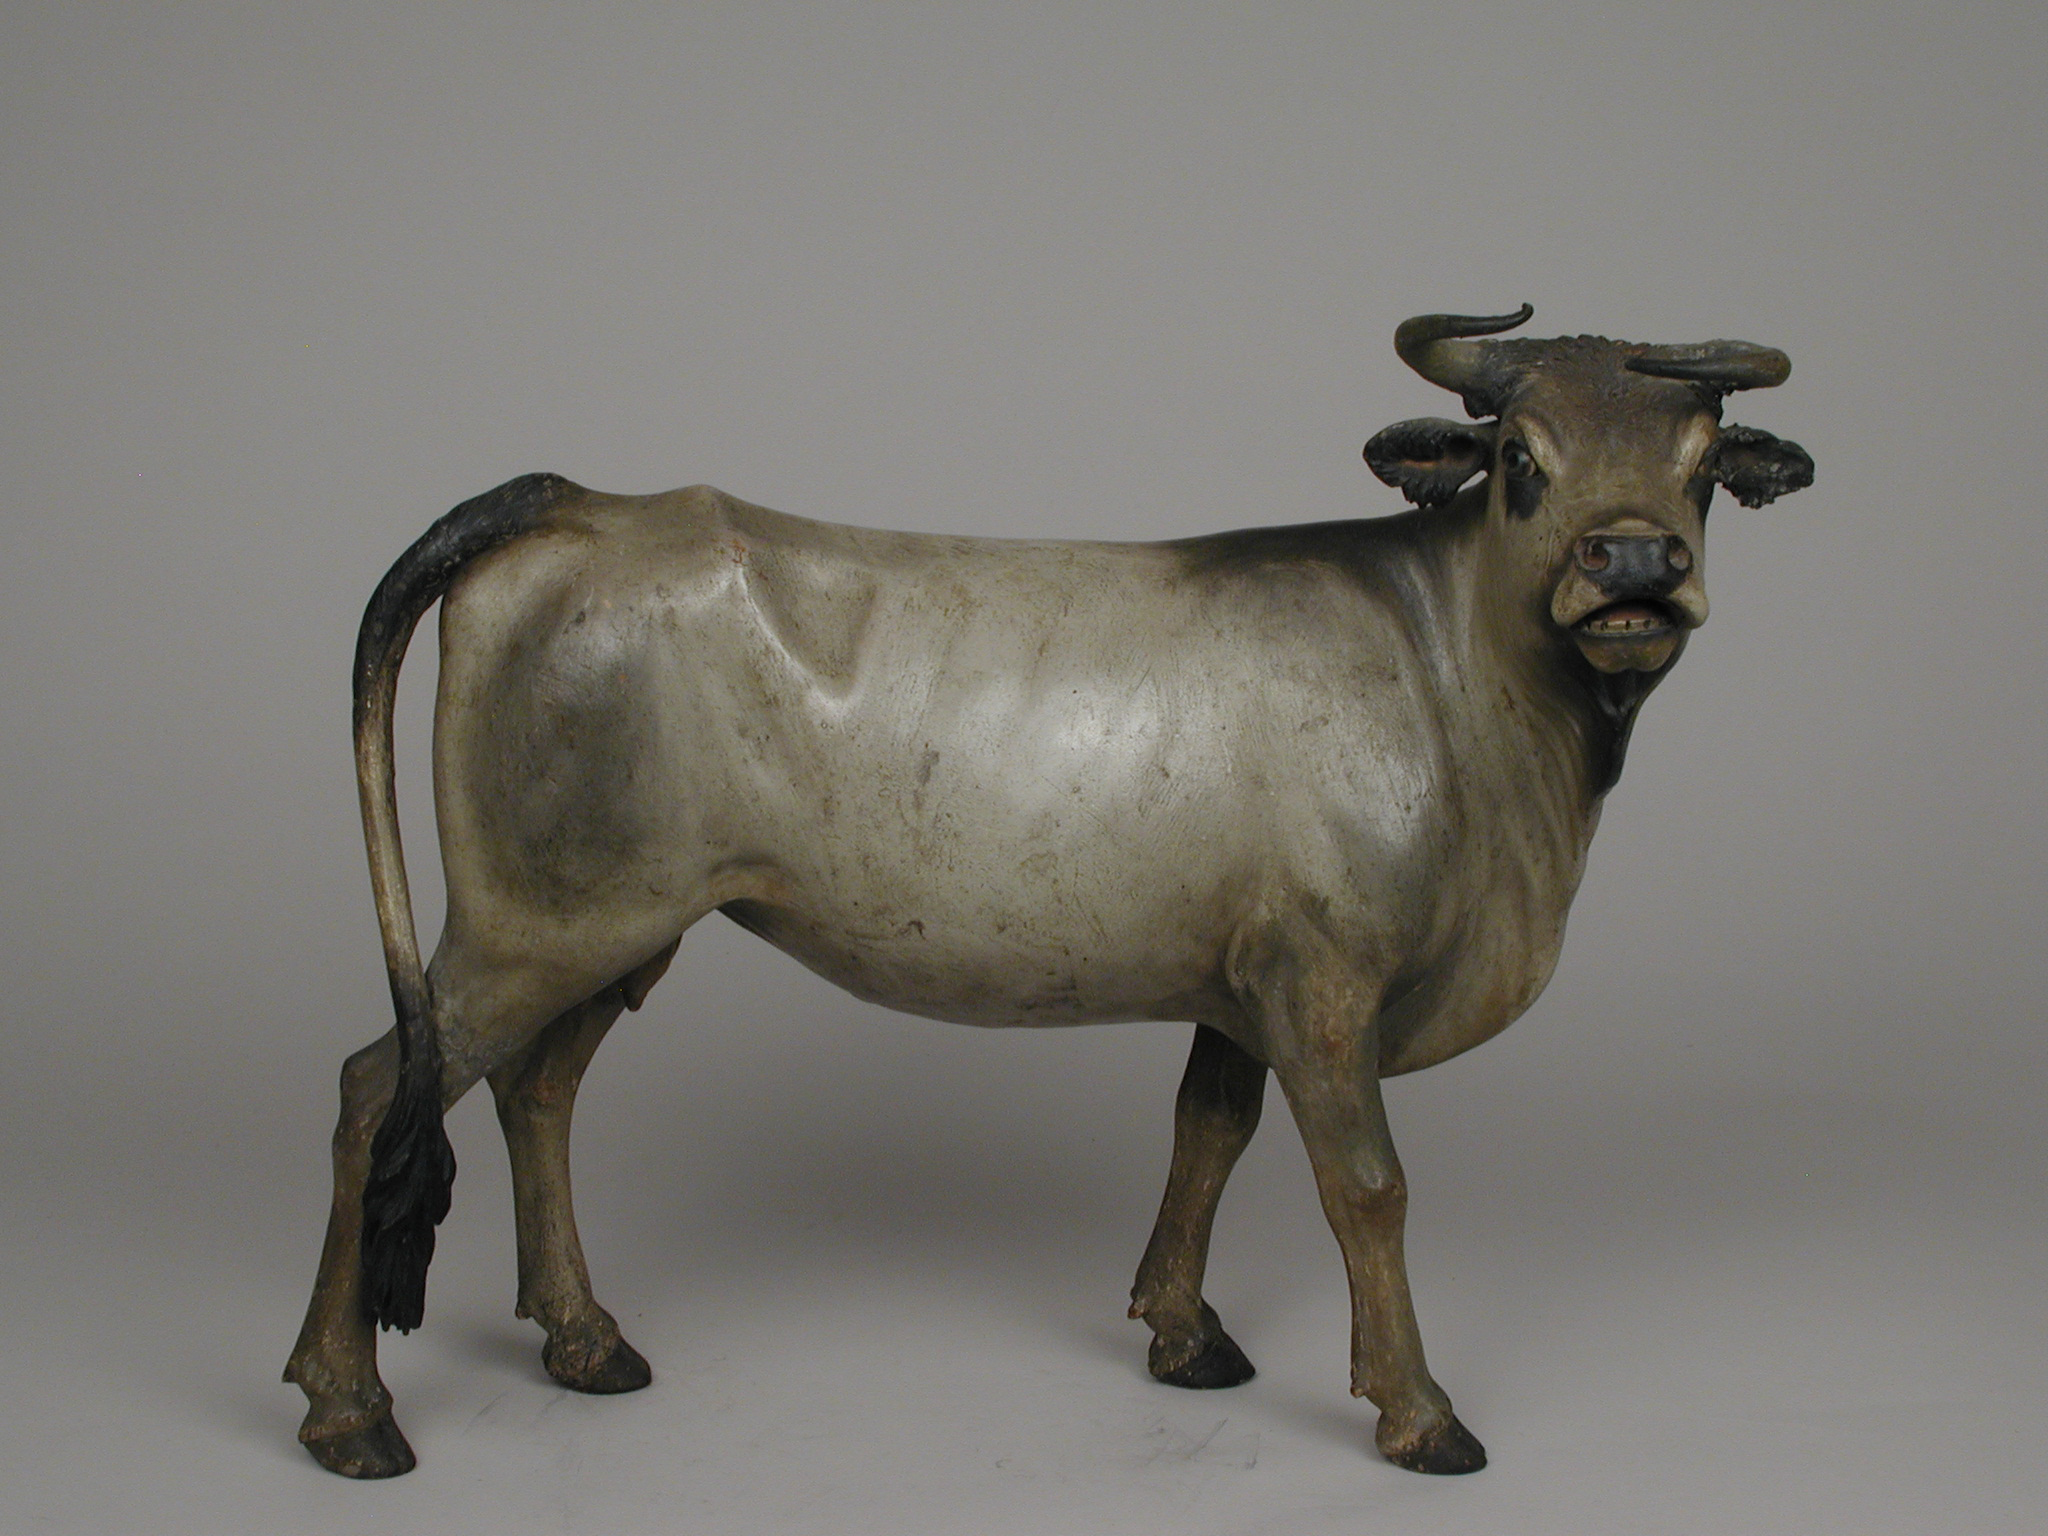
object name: crèche figure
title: Cow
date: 1701-1800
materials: terracotta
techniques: polychrome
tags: cows